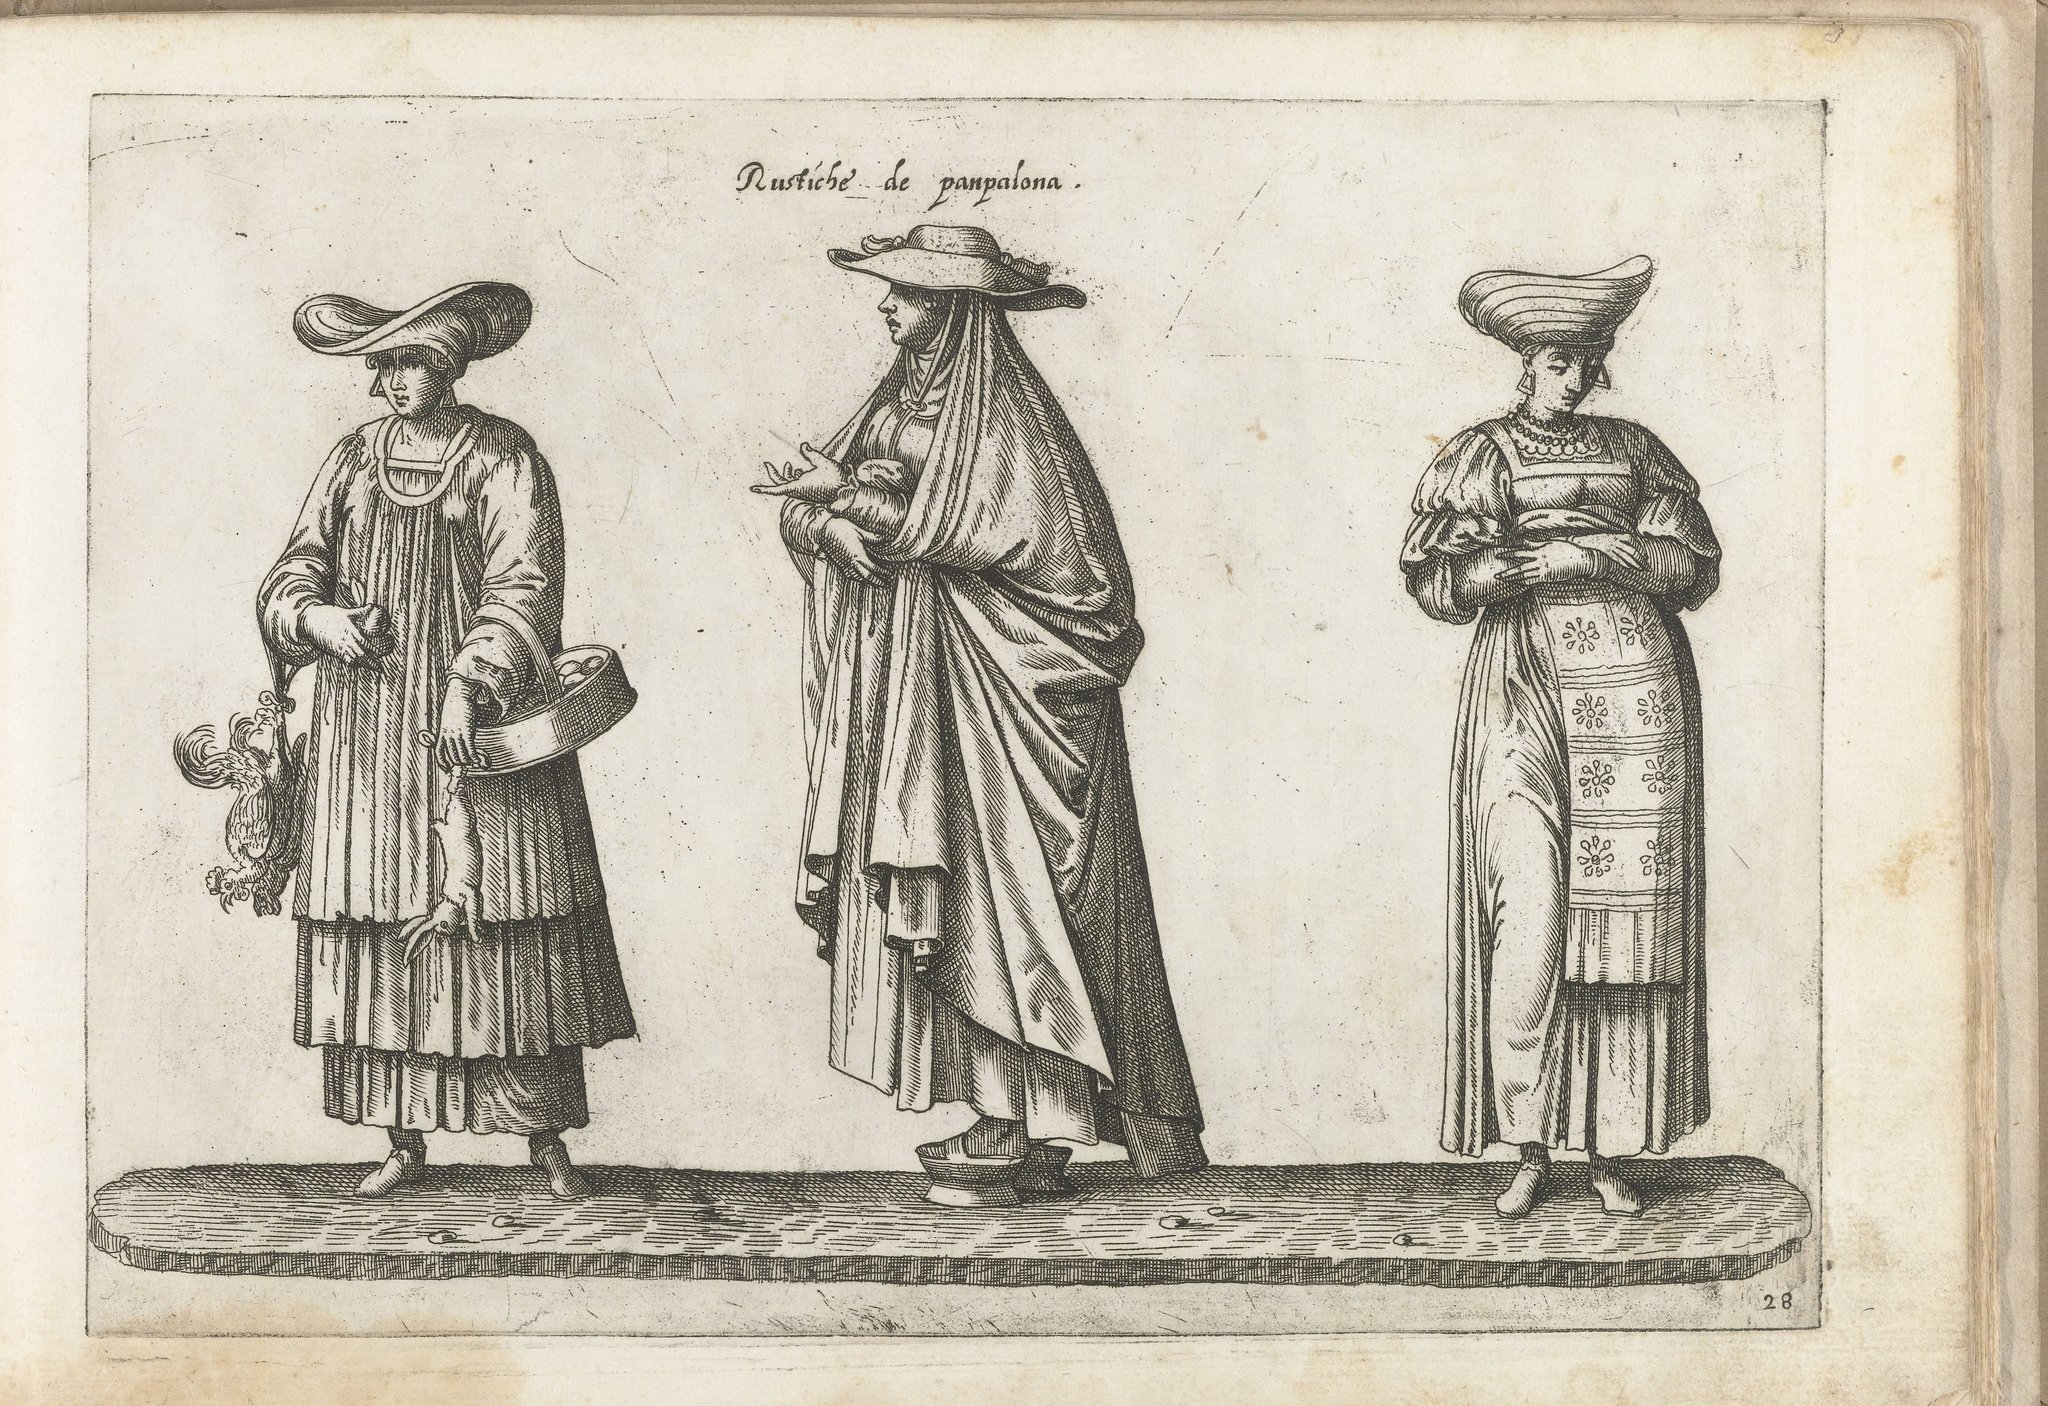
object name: costume print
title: Rustiche de panpalona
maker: bartolomeo grassi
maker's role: publisher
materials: paper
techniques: engraving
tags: europeans: spaniards (+ costume)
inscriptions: number: ‘27’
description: Drie vrouwen uit Pamplona. Prent nr. 28 uit album 'Dei veri ritratti degl'habiti di tvtte le parti del mondo intagliati in rame per opra di Bartolomeo Grassi', 1585.